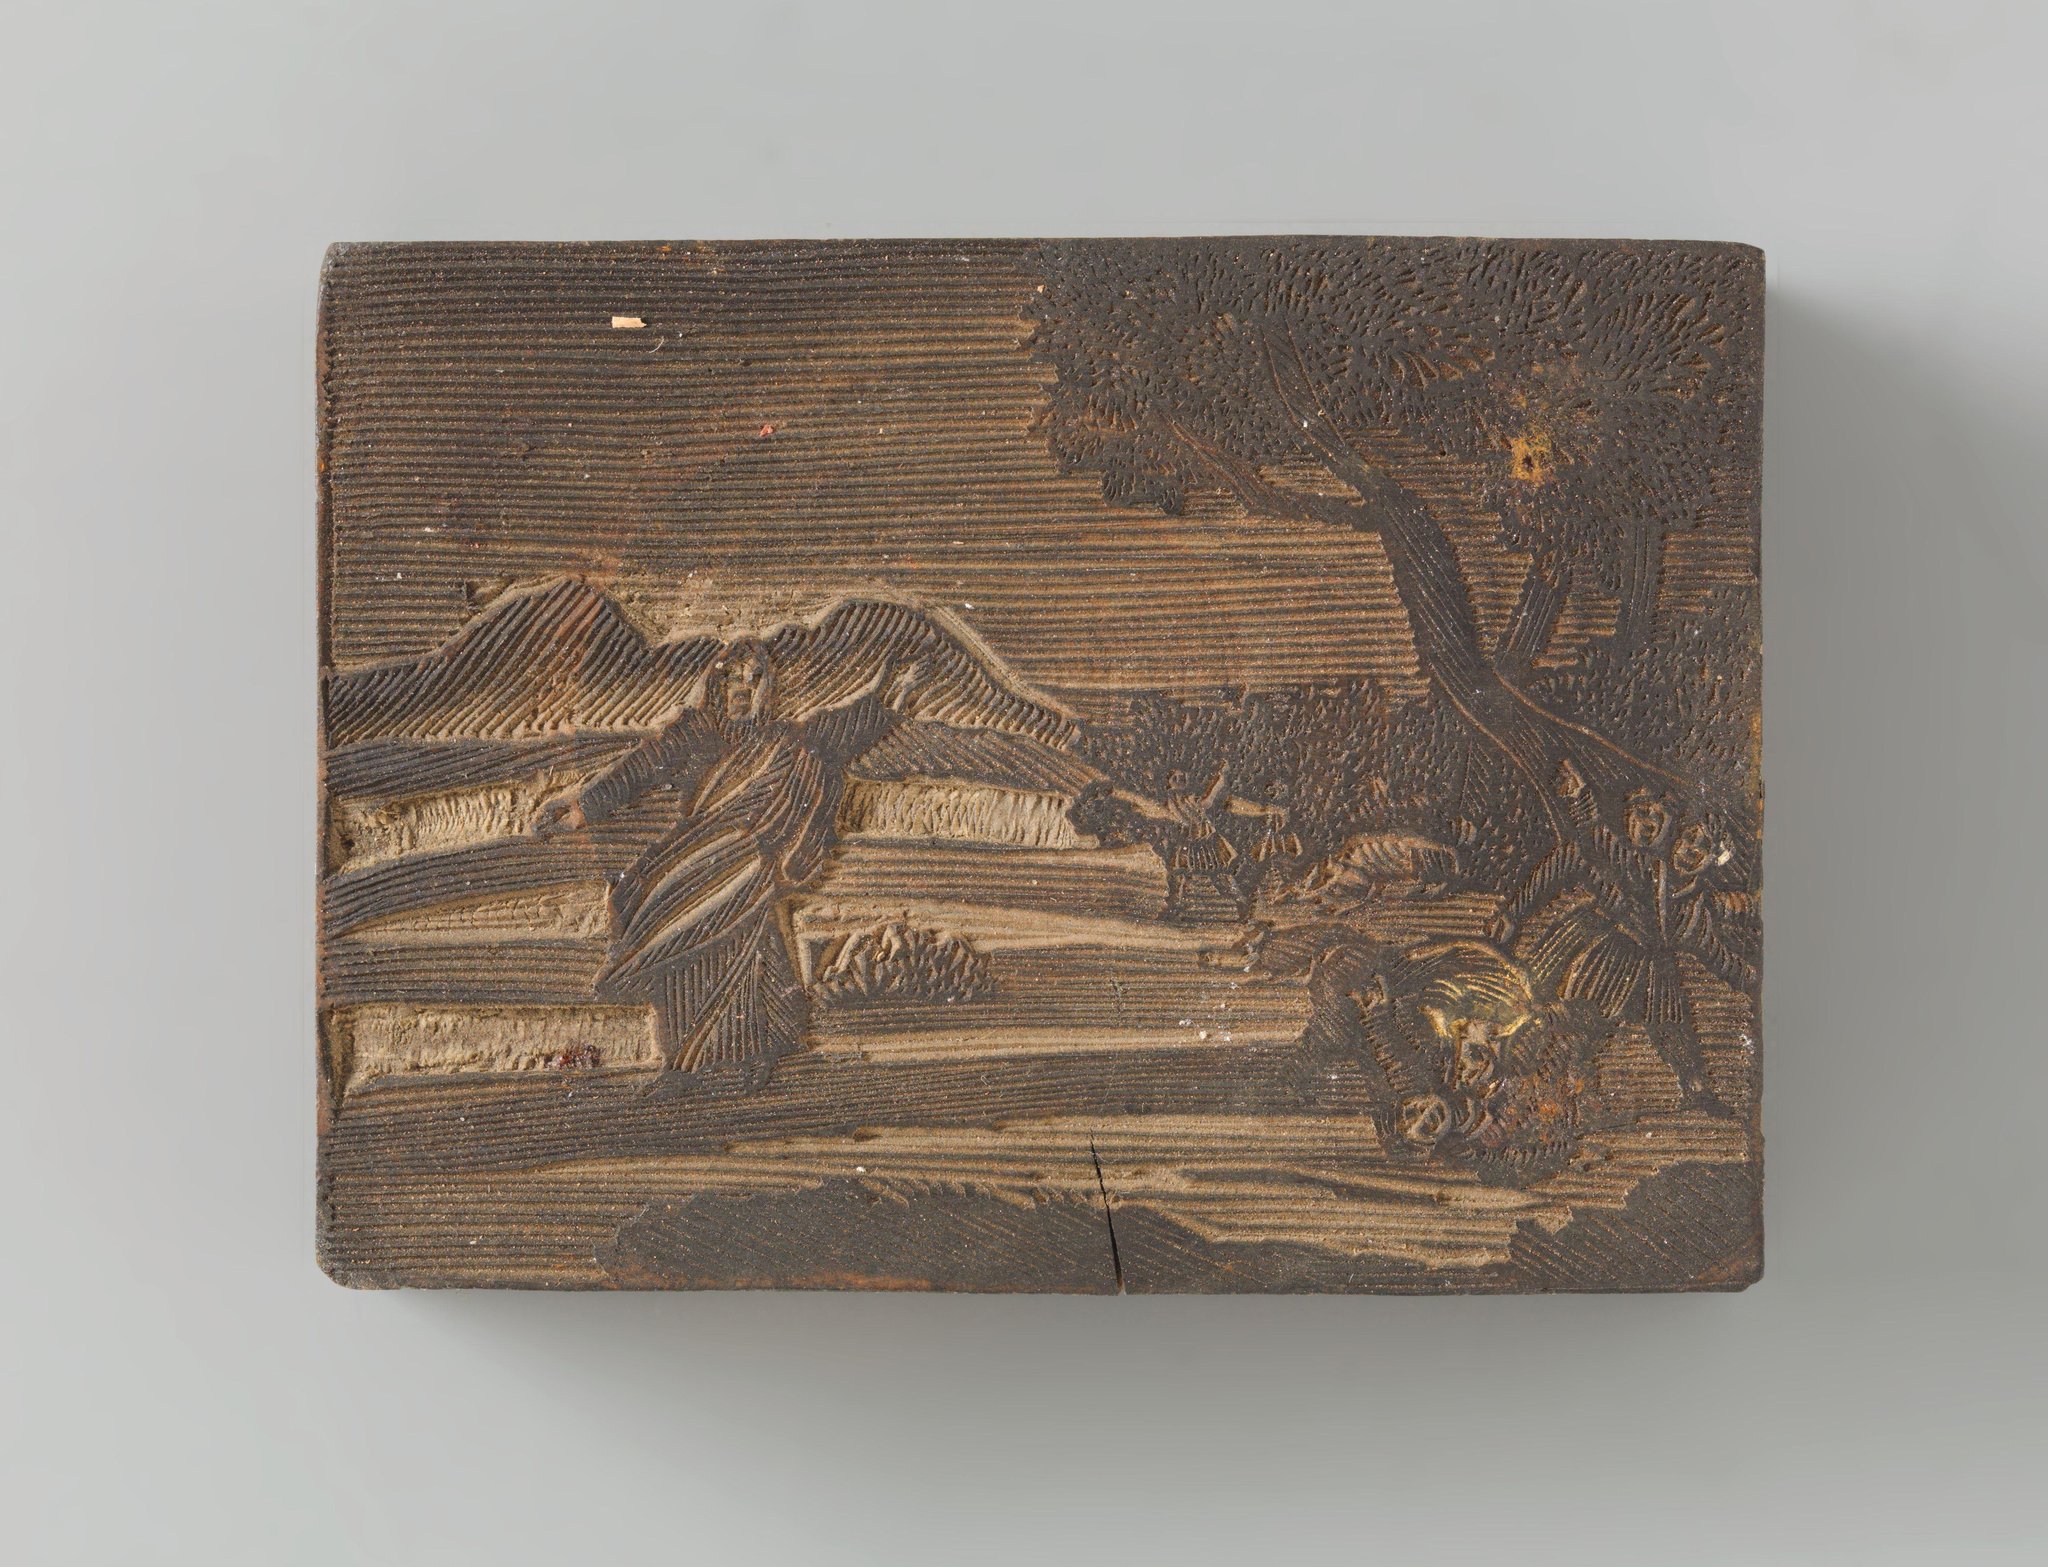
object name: wood block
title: Bijbel-illustraties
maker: Anonymous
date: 1550-1699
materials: wood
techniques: woodcut